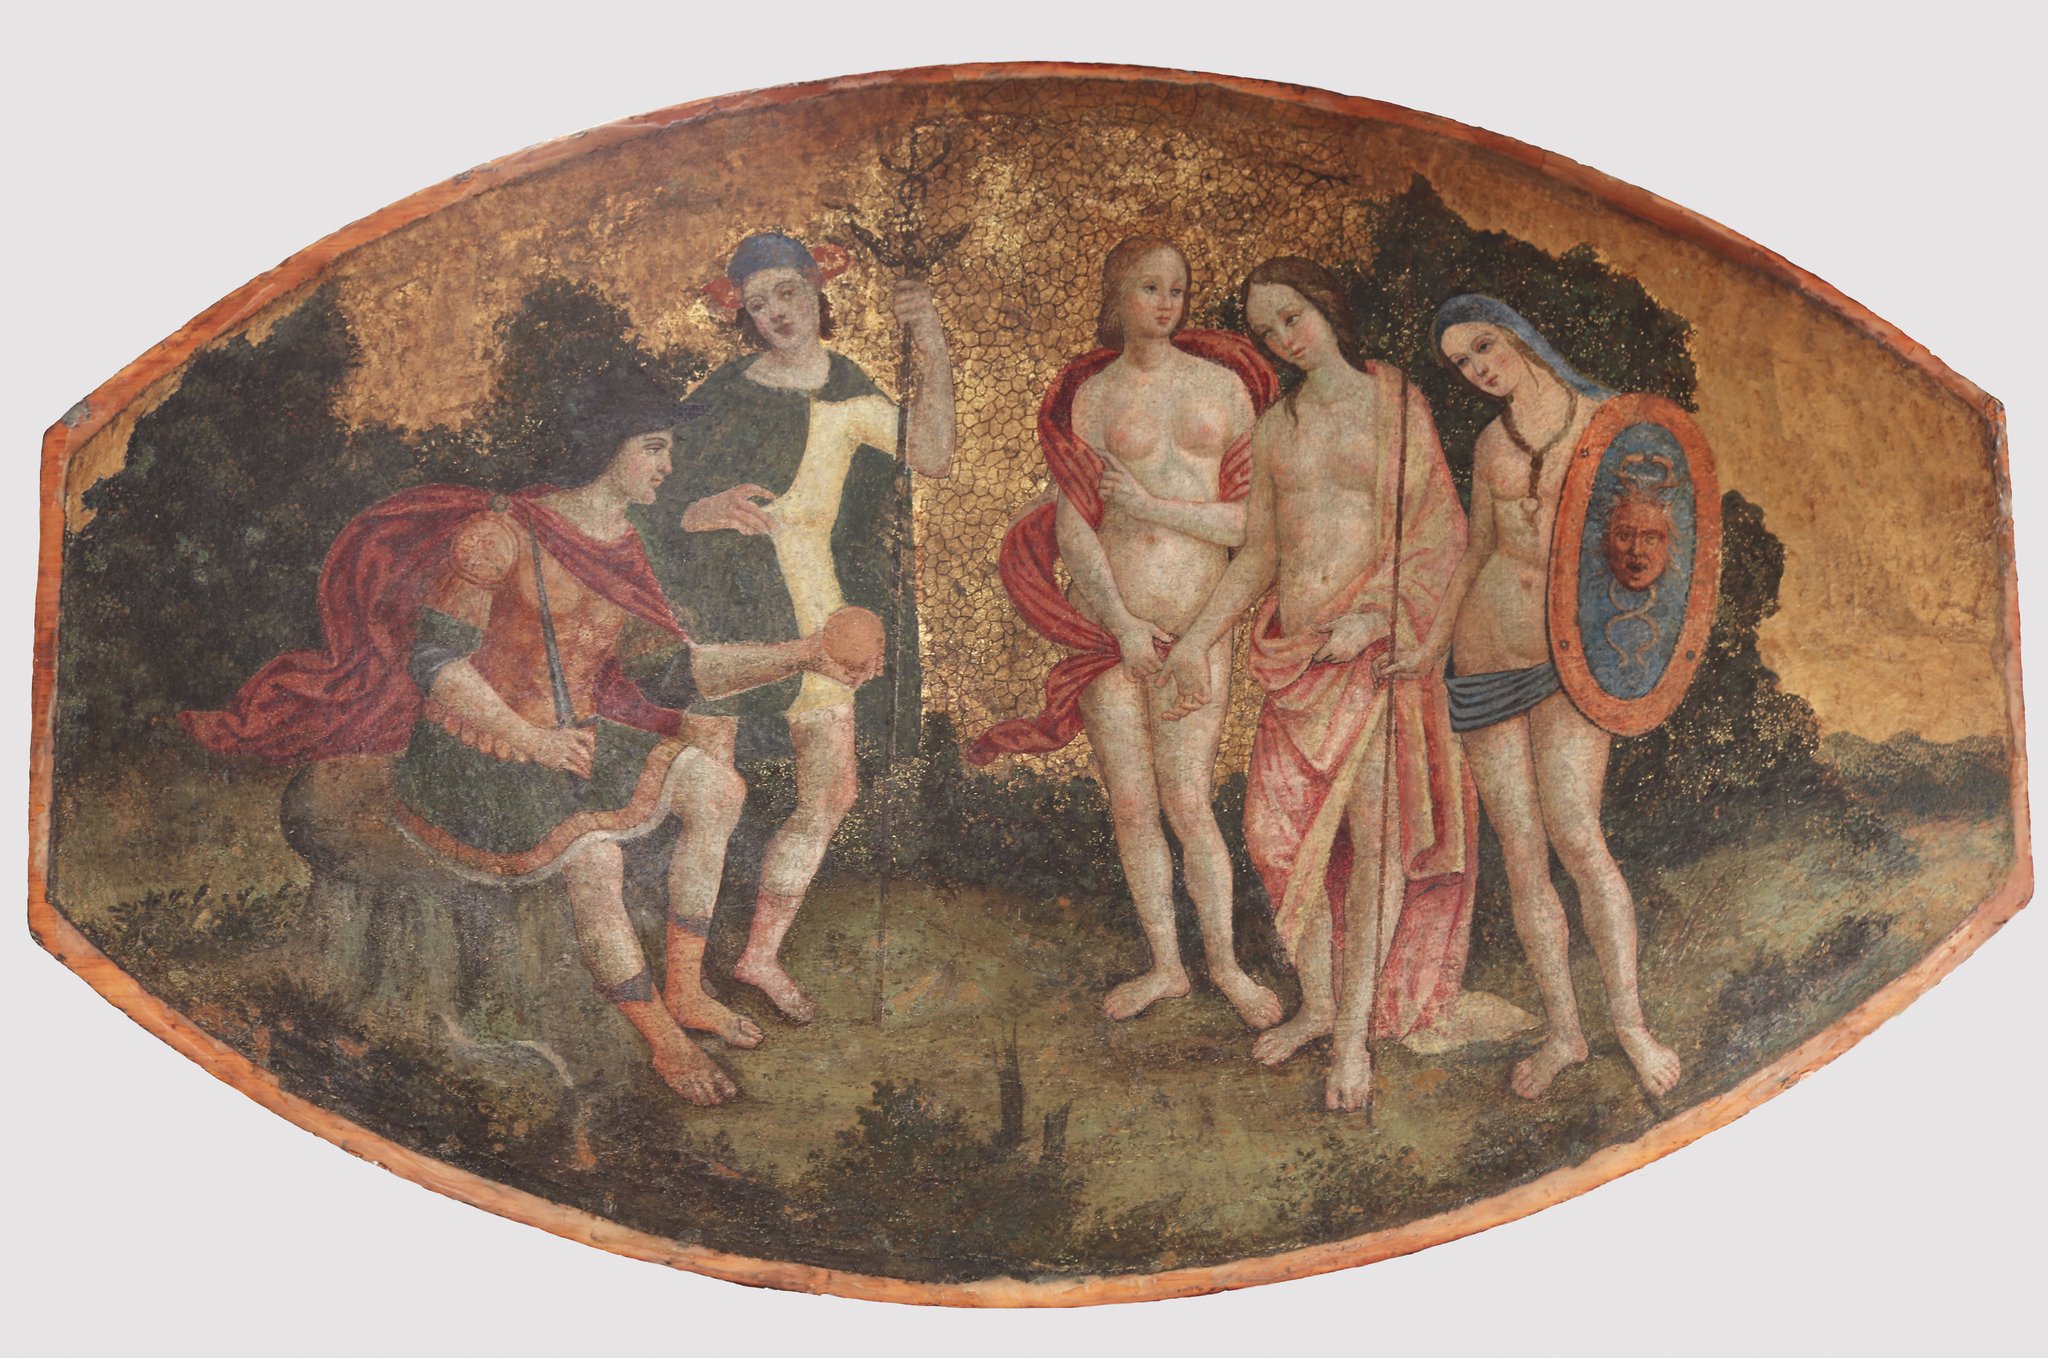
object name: ceiling panel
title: Judgment of Paris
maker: pinturicchio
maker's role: artist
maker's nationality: italian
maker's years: 1454-1513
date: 1509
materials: canvas, panel, wood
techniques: fresco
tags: men,female nudes,paris